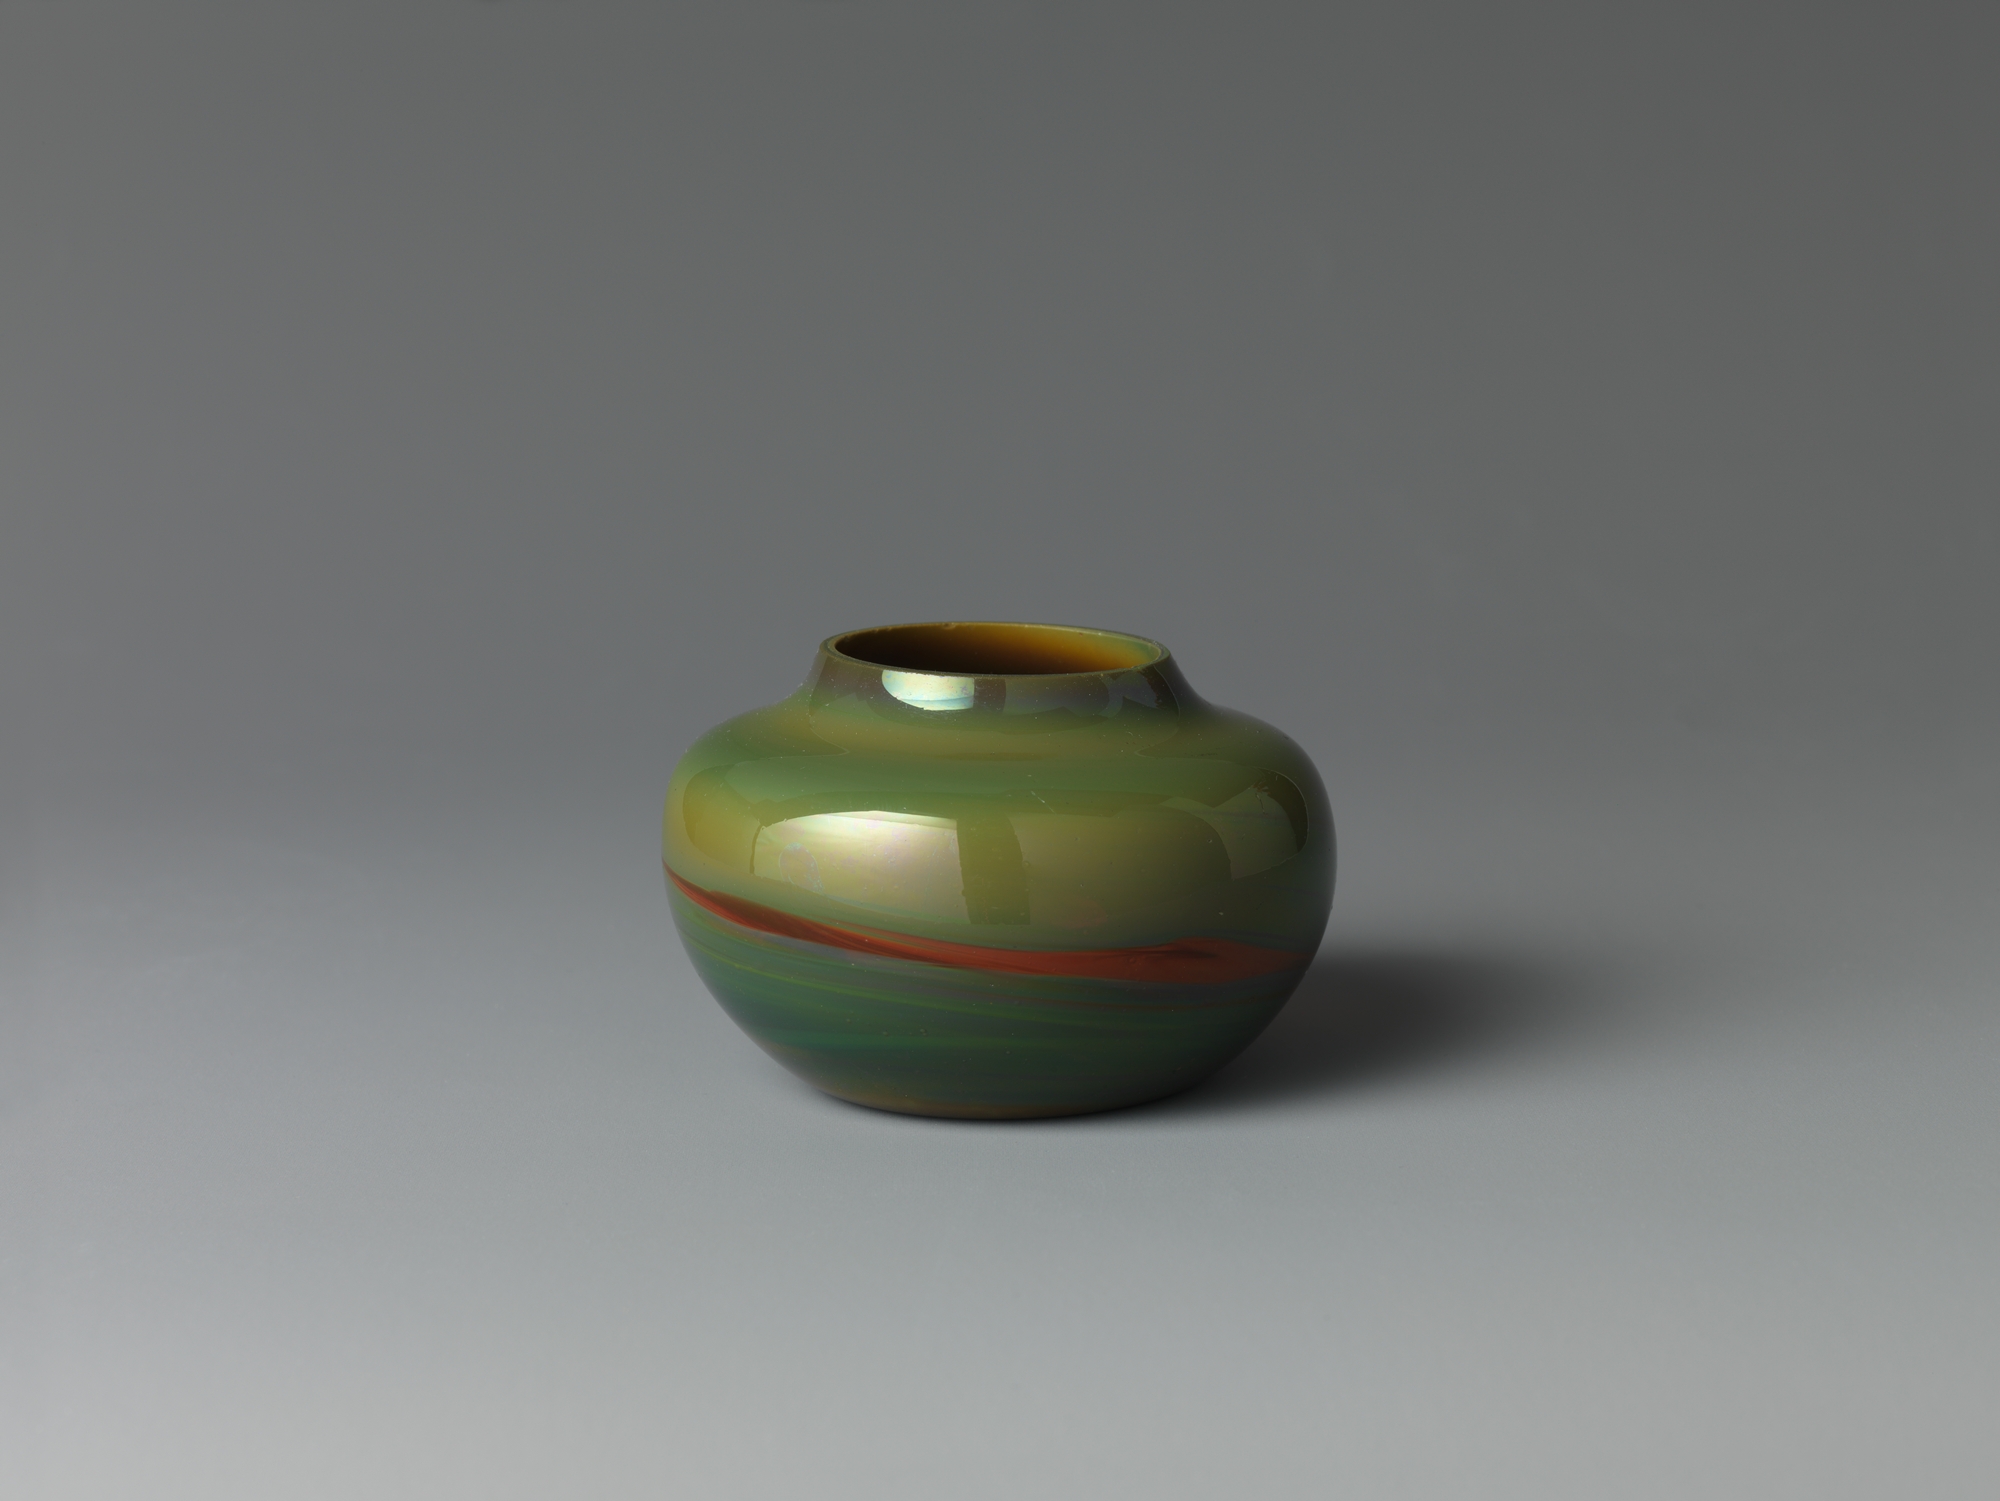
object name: jar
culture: japanese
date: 1834-1866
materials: glass